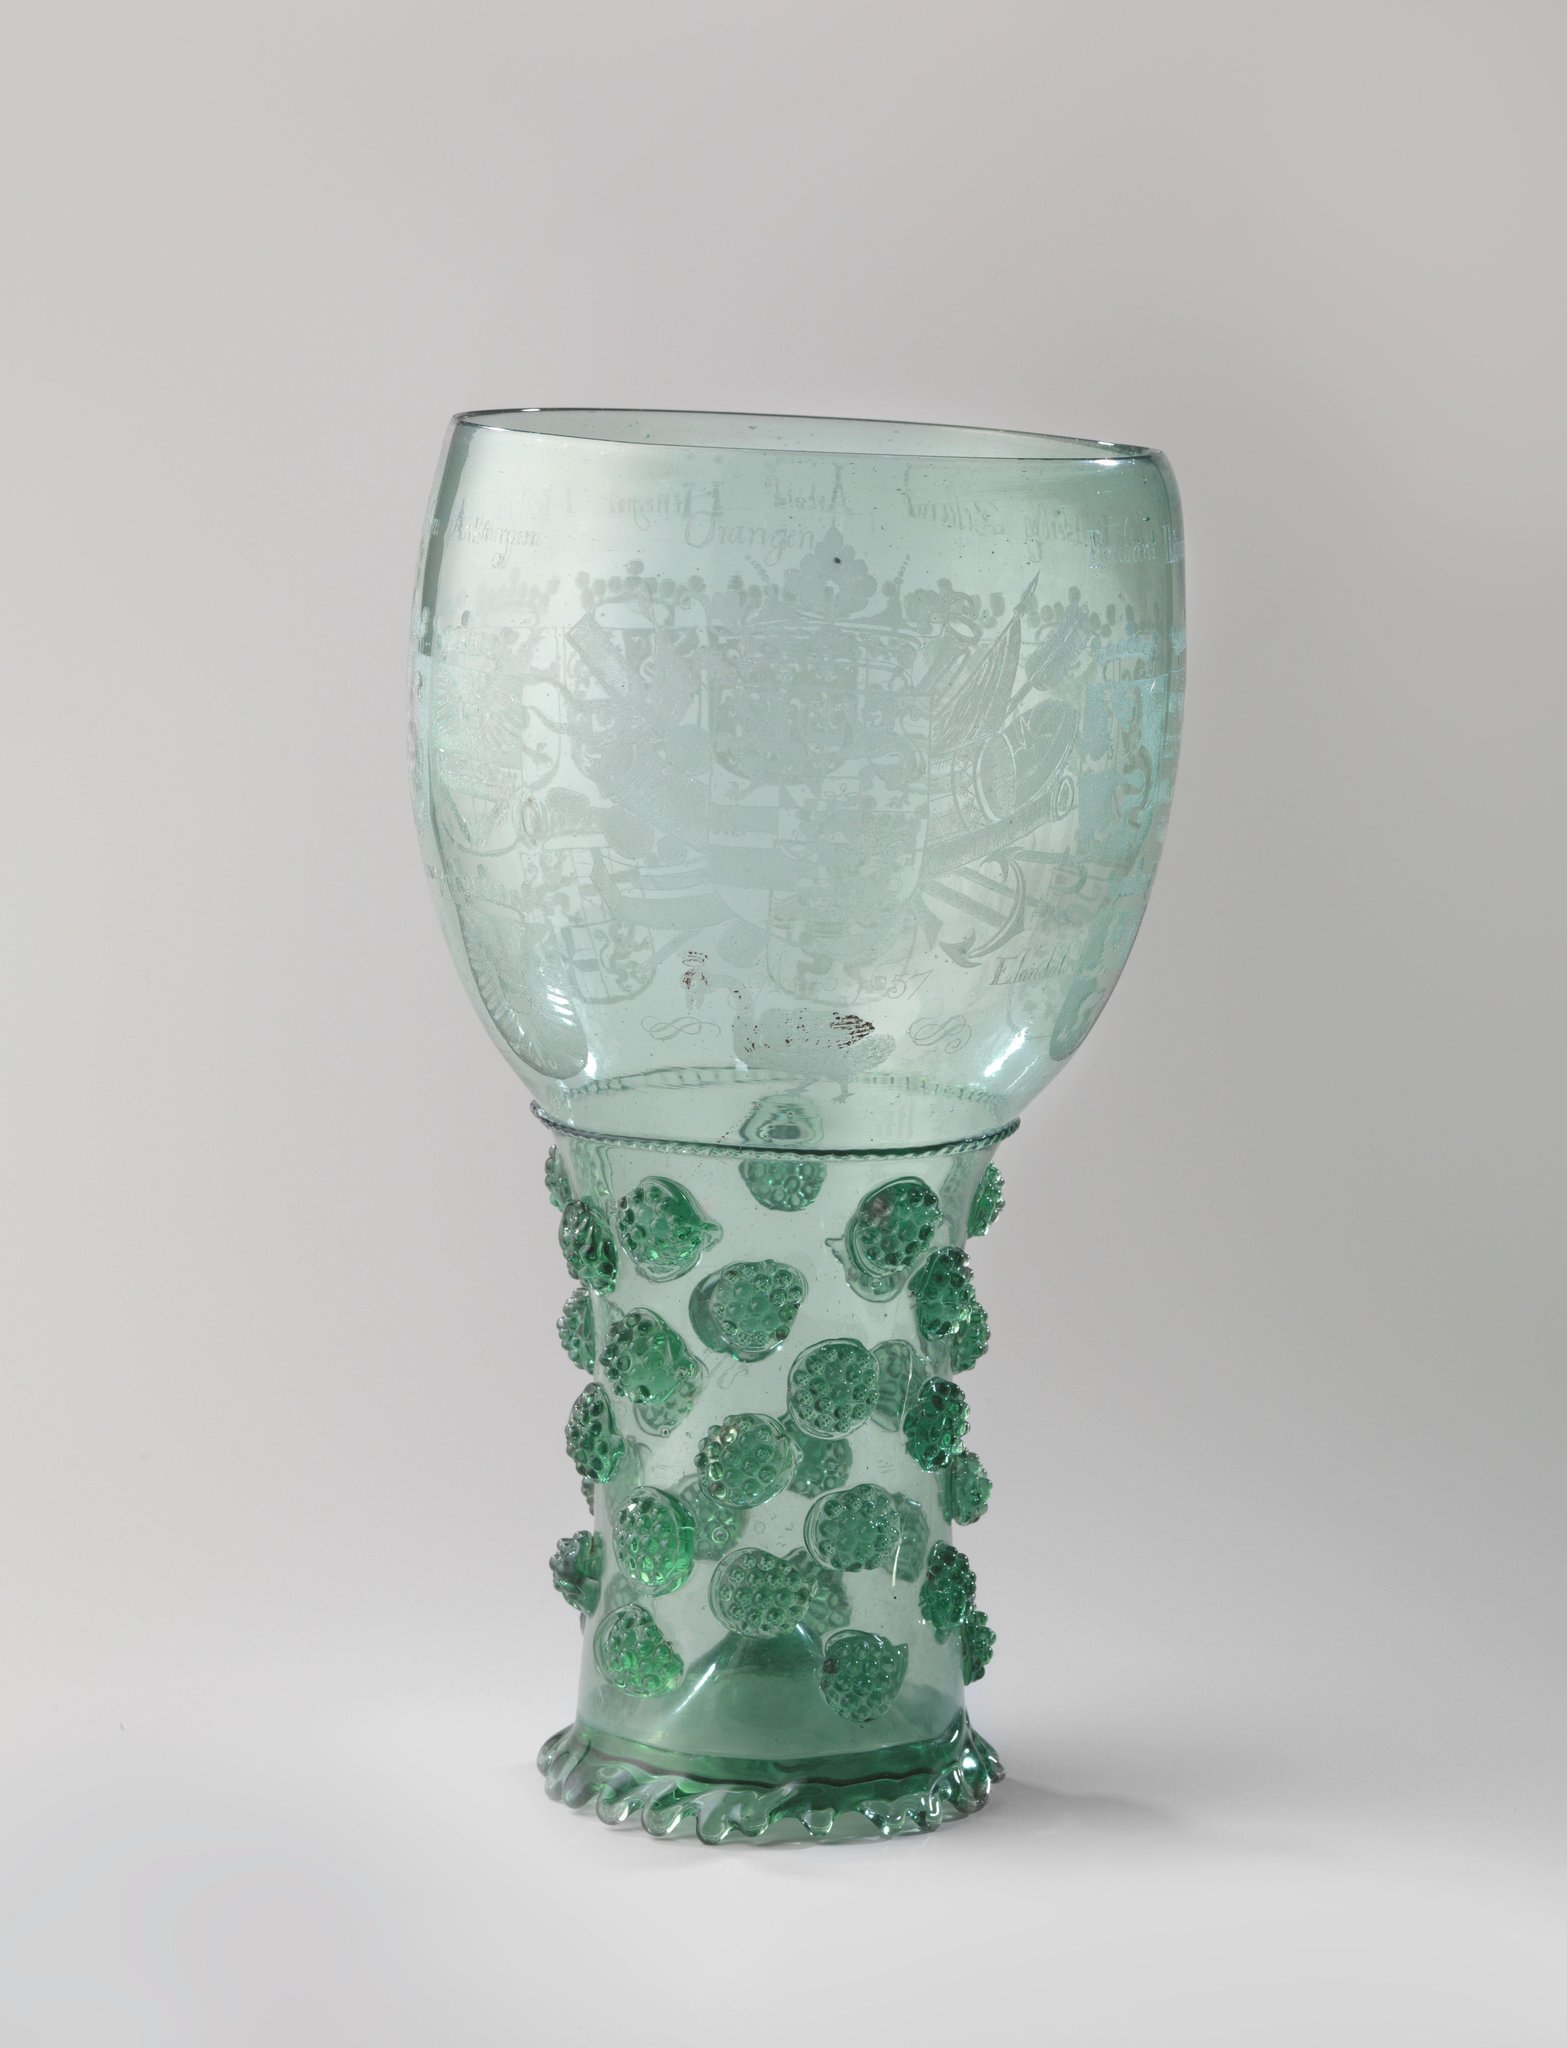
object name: roemer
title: Roemer met het wapen van Willem III omgeven door de wapens van provincies en steden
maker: Anonymous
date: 1657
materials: glass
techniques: diamond point engraving, glassblowing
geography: northern netherlands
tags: the hague, william iii (prince of orange and king of england, scotland, and ireland)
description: In druppels uitgetrokken standring. Diep ingestoken bodem. De hoge stam, die bezet is met zeven rijen braamnoppen, is als één geheel geblazen met de gebogen kelk. De overgang van de stam naar de kelk is aangegeven door een geribde draad. Op de kelk is het wapen gegraveerd van Stadhouder prins Willem III, omgeven door wapentrofeeën. Erboven staat het woord 'Orangen', eronder het jaartal 'Anno 1657' en een gekroonde jonge zwaan. Rondom zijn de wapens gegraveerd van 'Brabant, Limburgh, Gelderland, Lutsenburg, Zeland, Artois, Hénegou, Hollant, Namuier, Zutphen, Antwerpen, Elanderlant, Friesland, Overijssel, Utrecht, Mechelen en Groningen'. Op de stam staat nogmaals het jaartal 1657 en de letter 'F'.